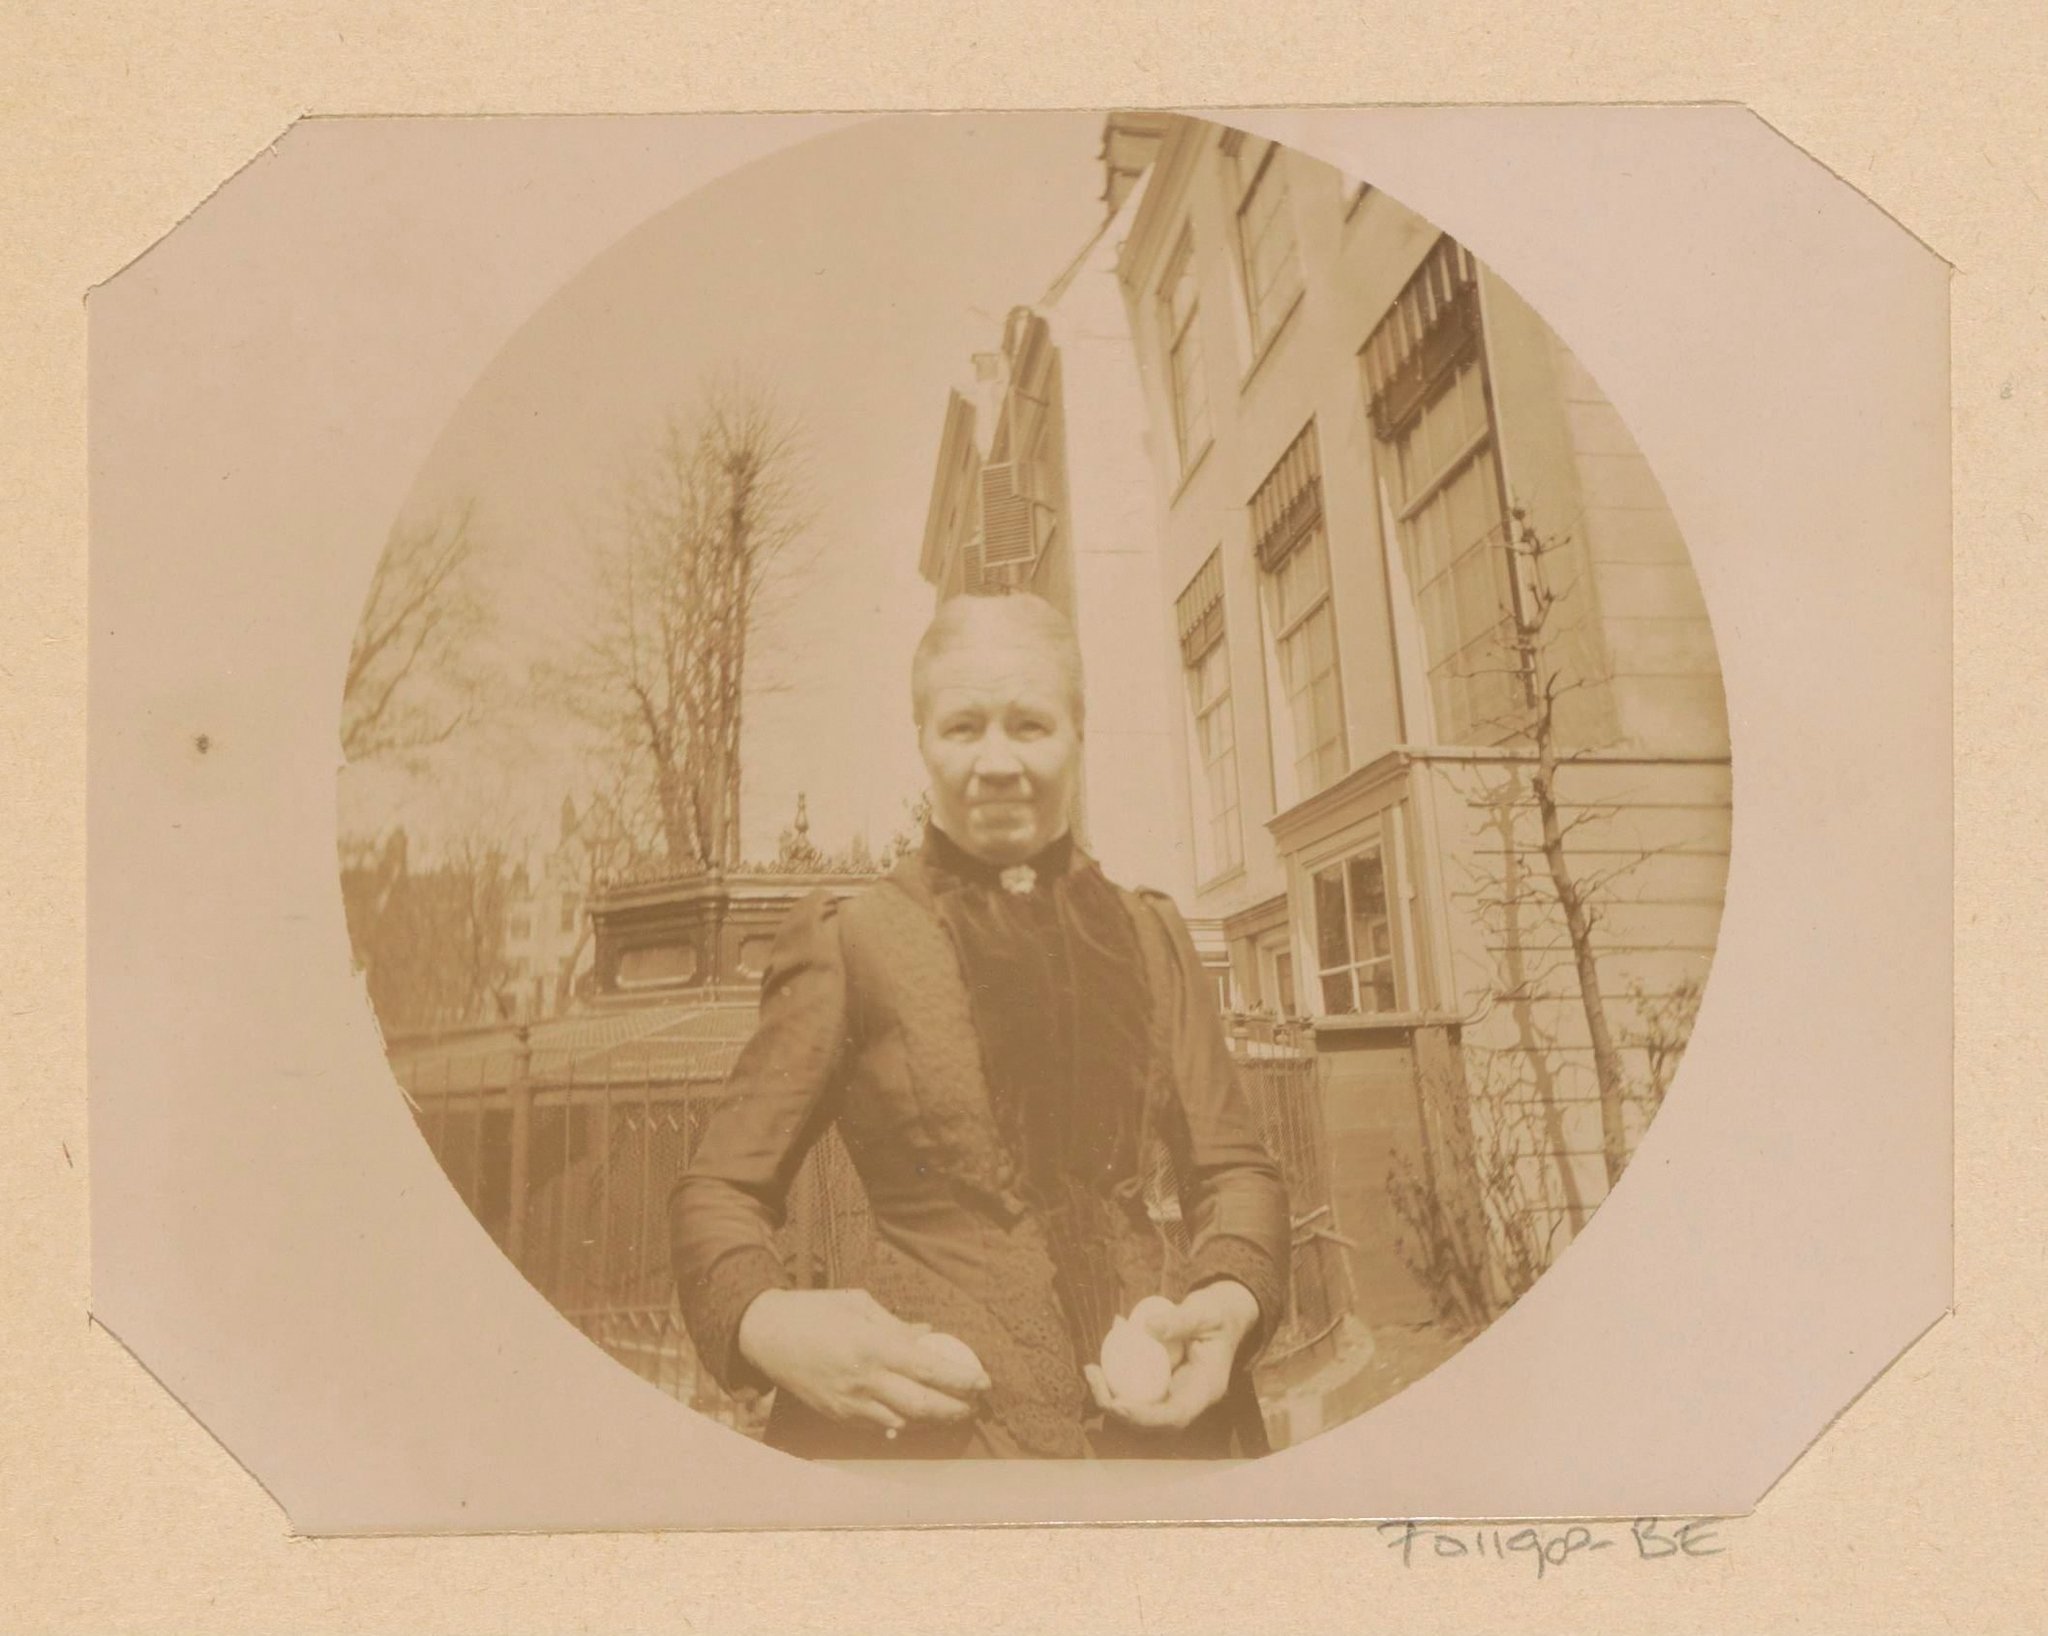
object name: photograph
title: Portret van Lucia Wilhelmina Piek-Jolles in de achtertuin van Herengracht 258, Amsterdam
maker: johanna margaretha piek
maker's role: fotograaf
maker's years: 1870-1947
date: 1889-1893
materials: paper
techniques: gelatin silver print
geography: amsterdam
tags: amsterdam, adult woman, historical persons